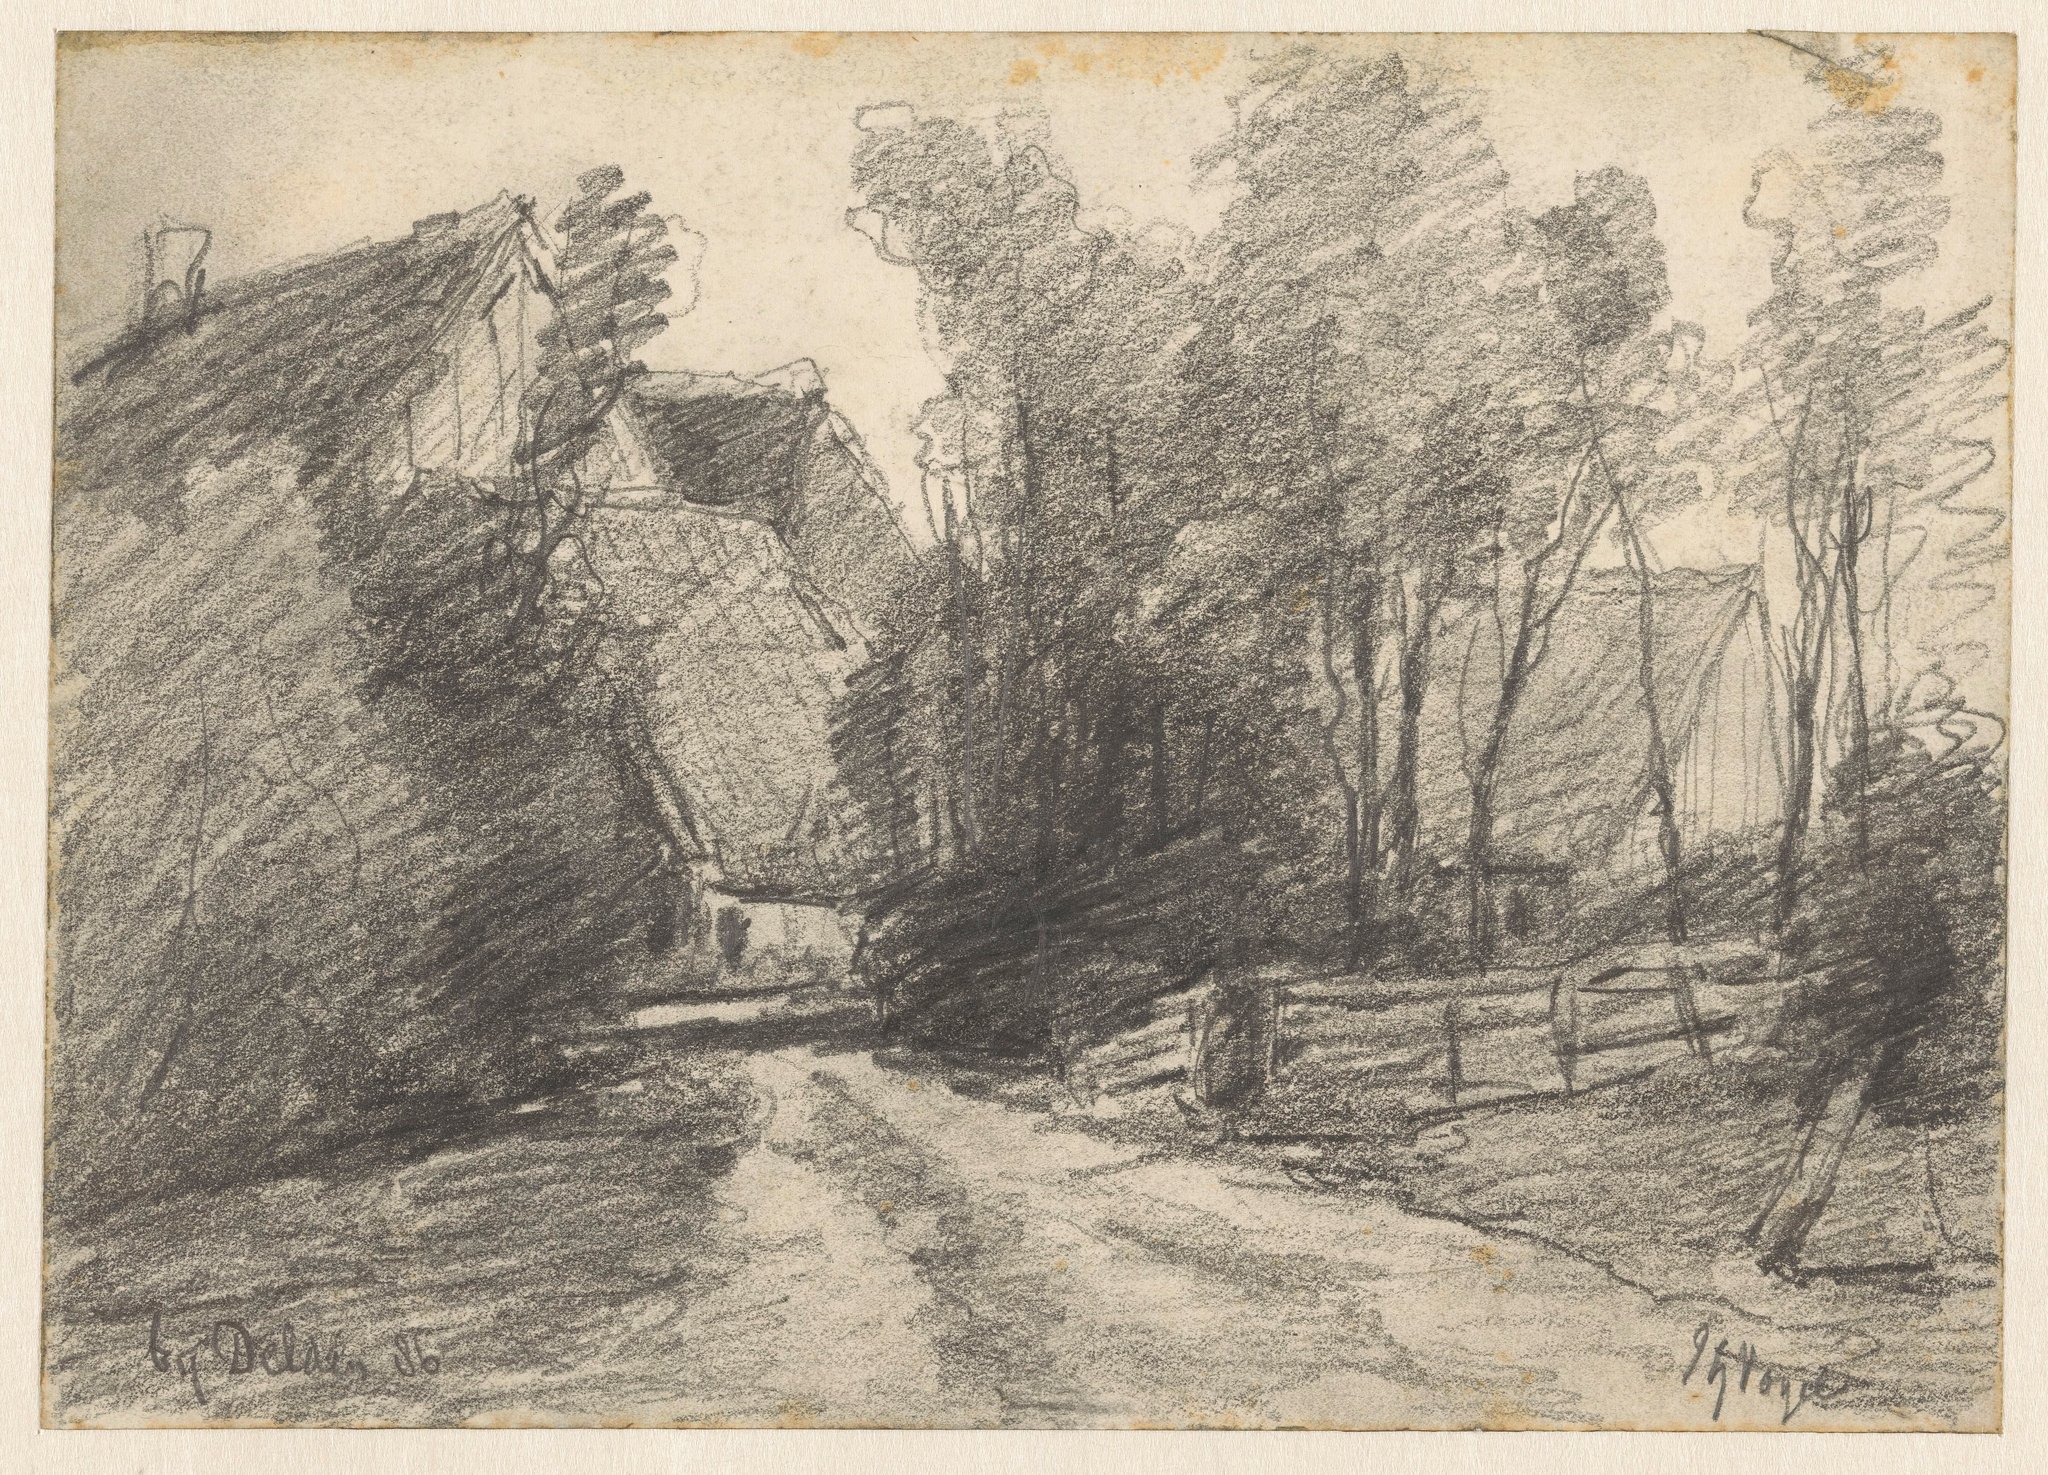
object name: drawing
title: Boerderij tussen bomen bij Delden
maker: johannes gijsbert vogel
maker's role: draughtsman, painter, print maker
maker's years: 1828-1915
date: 1886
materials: chalk, paper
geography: delden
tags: forest, wood, farm (building)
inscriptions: date